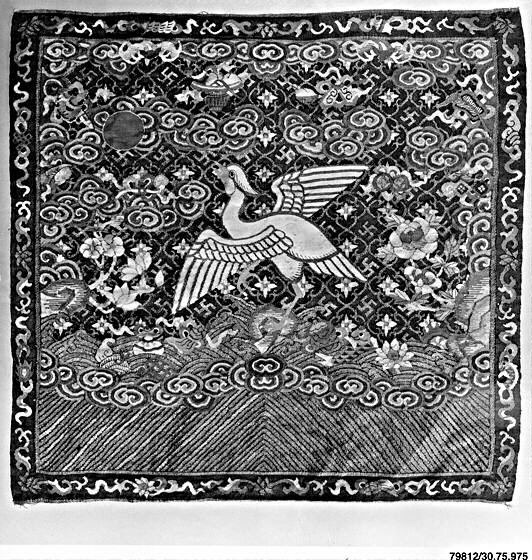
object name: rank badge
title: Rank Badge with Eastern Egret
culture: chinese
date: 1767-1833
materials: metal thread, silk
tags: bats,birds